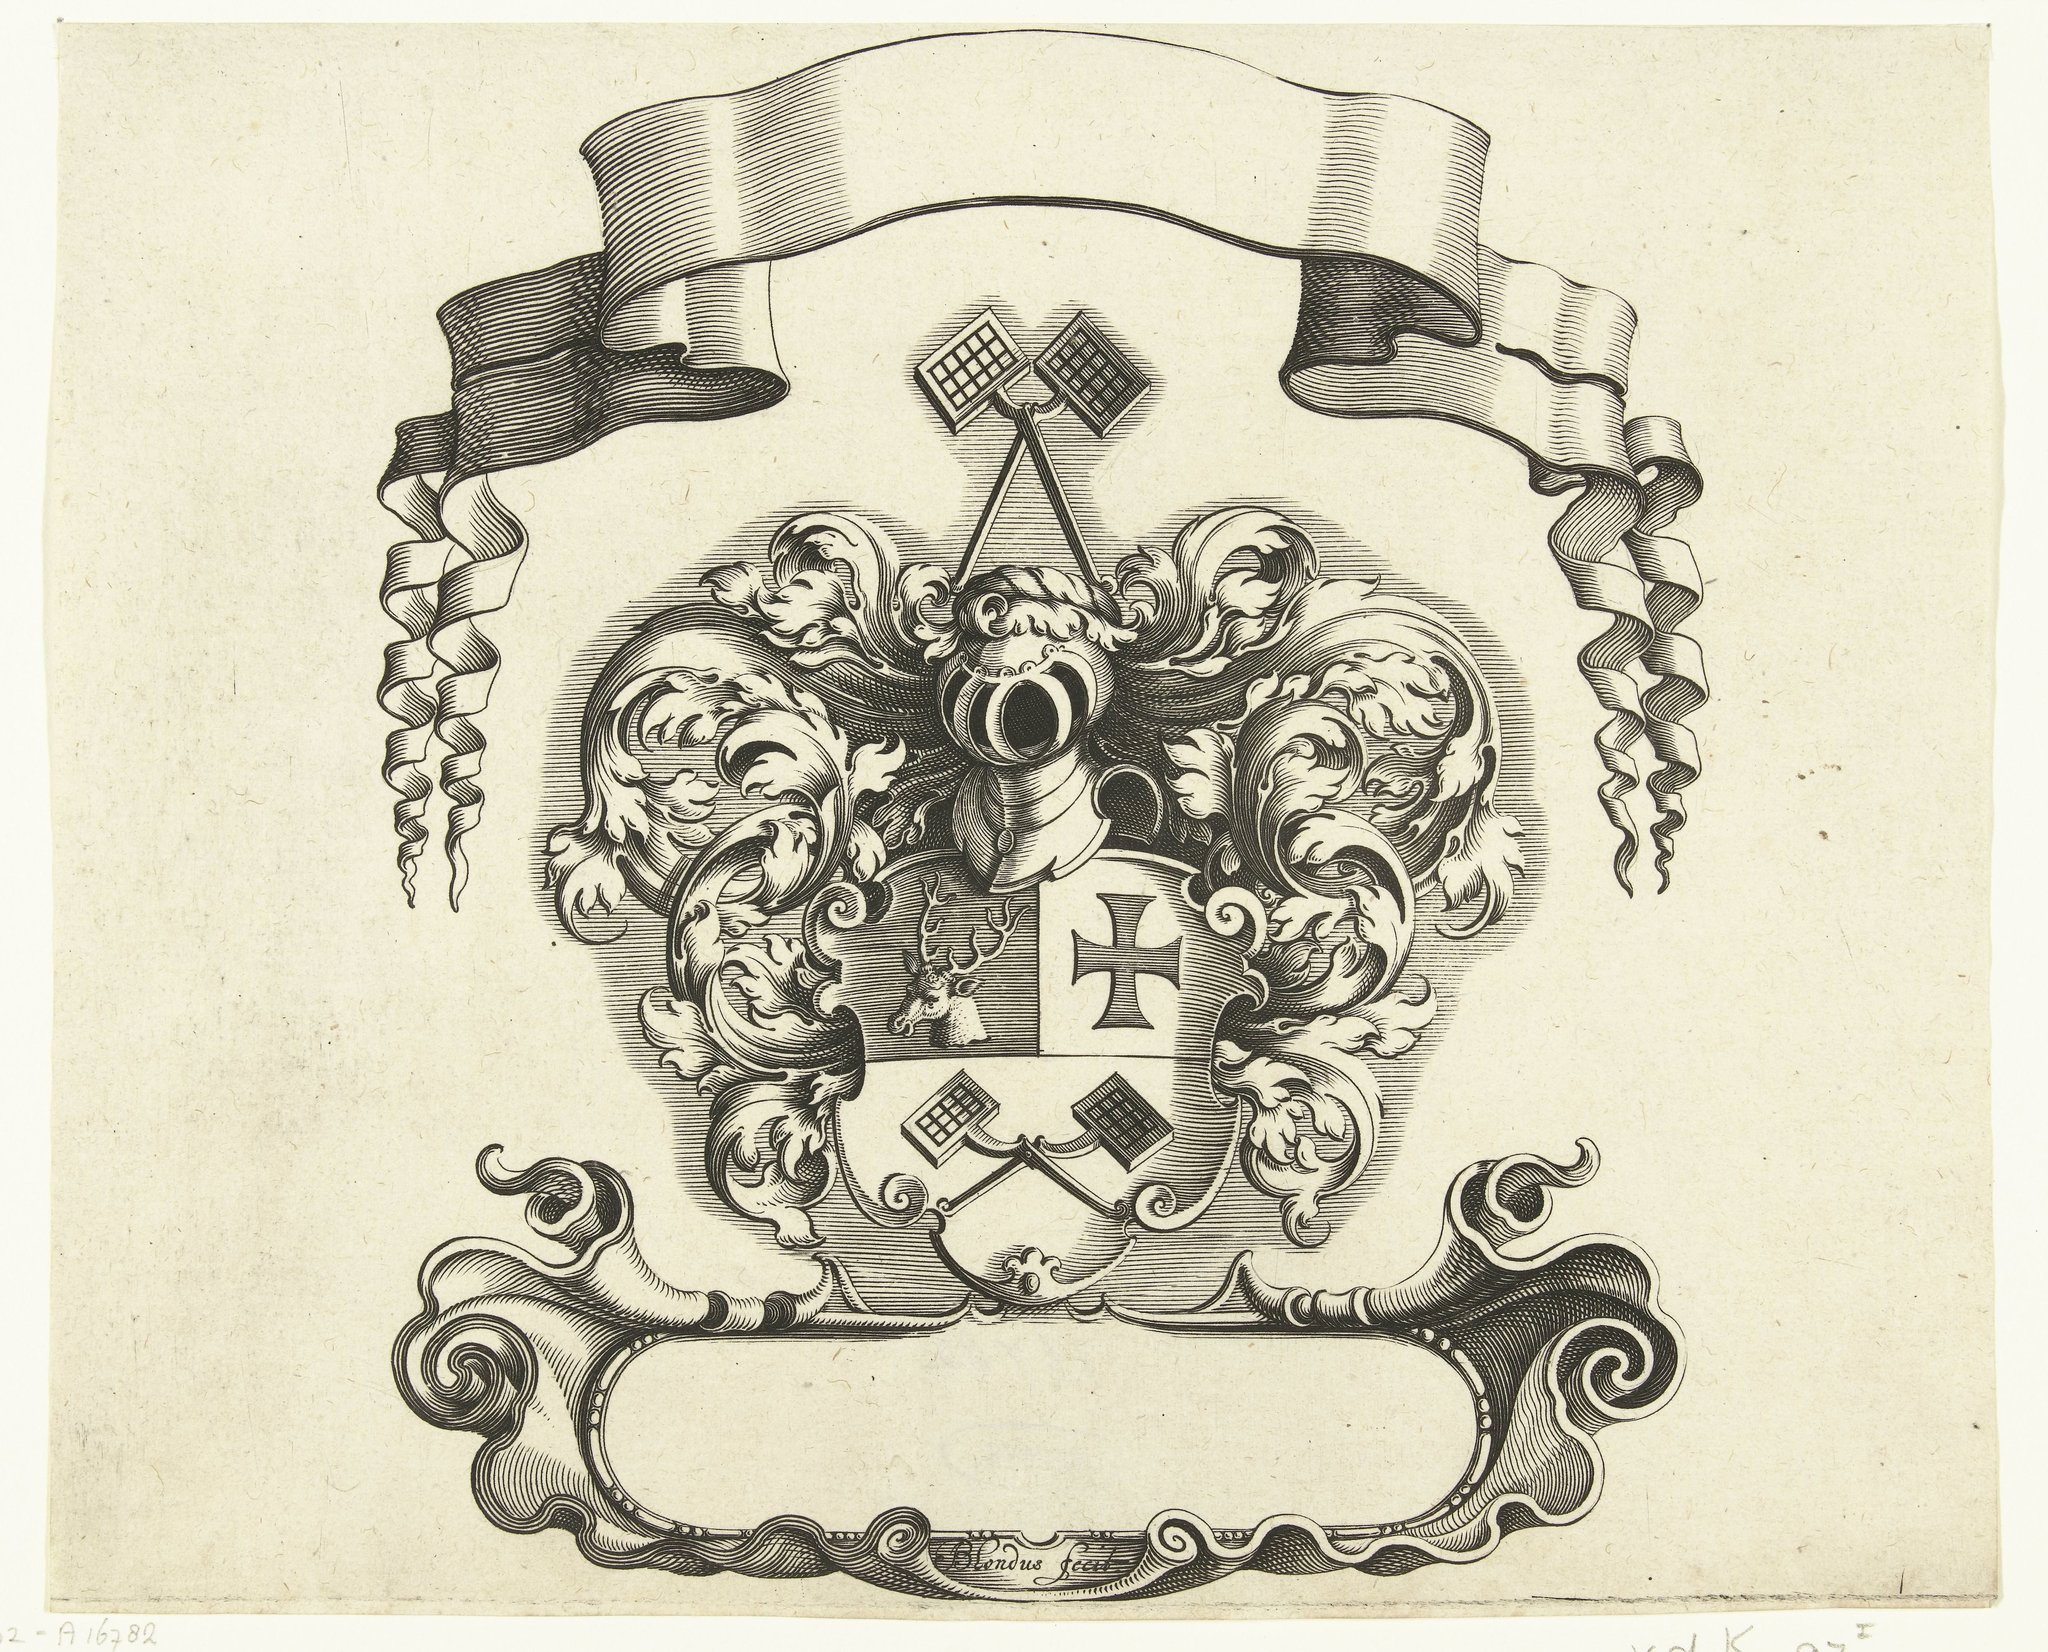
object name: print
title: Secretum Musarum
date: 1615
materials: paper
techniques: etching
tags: armorial bearing, heraldry